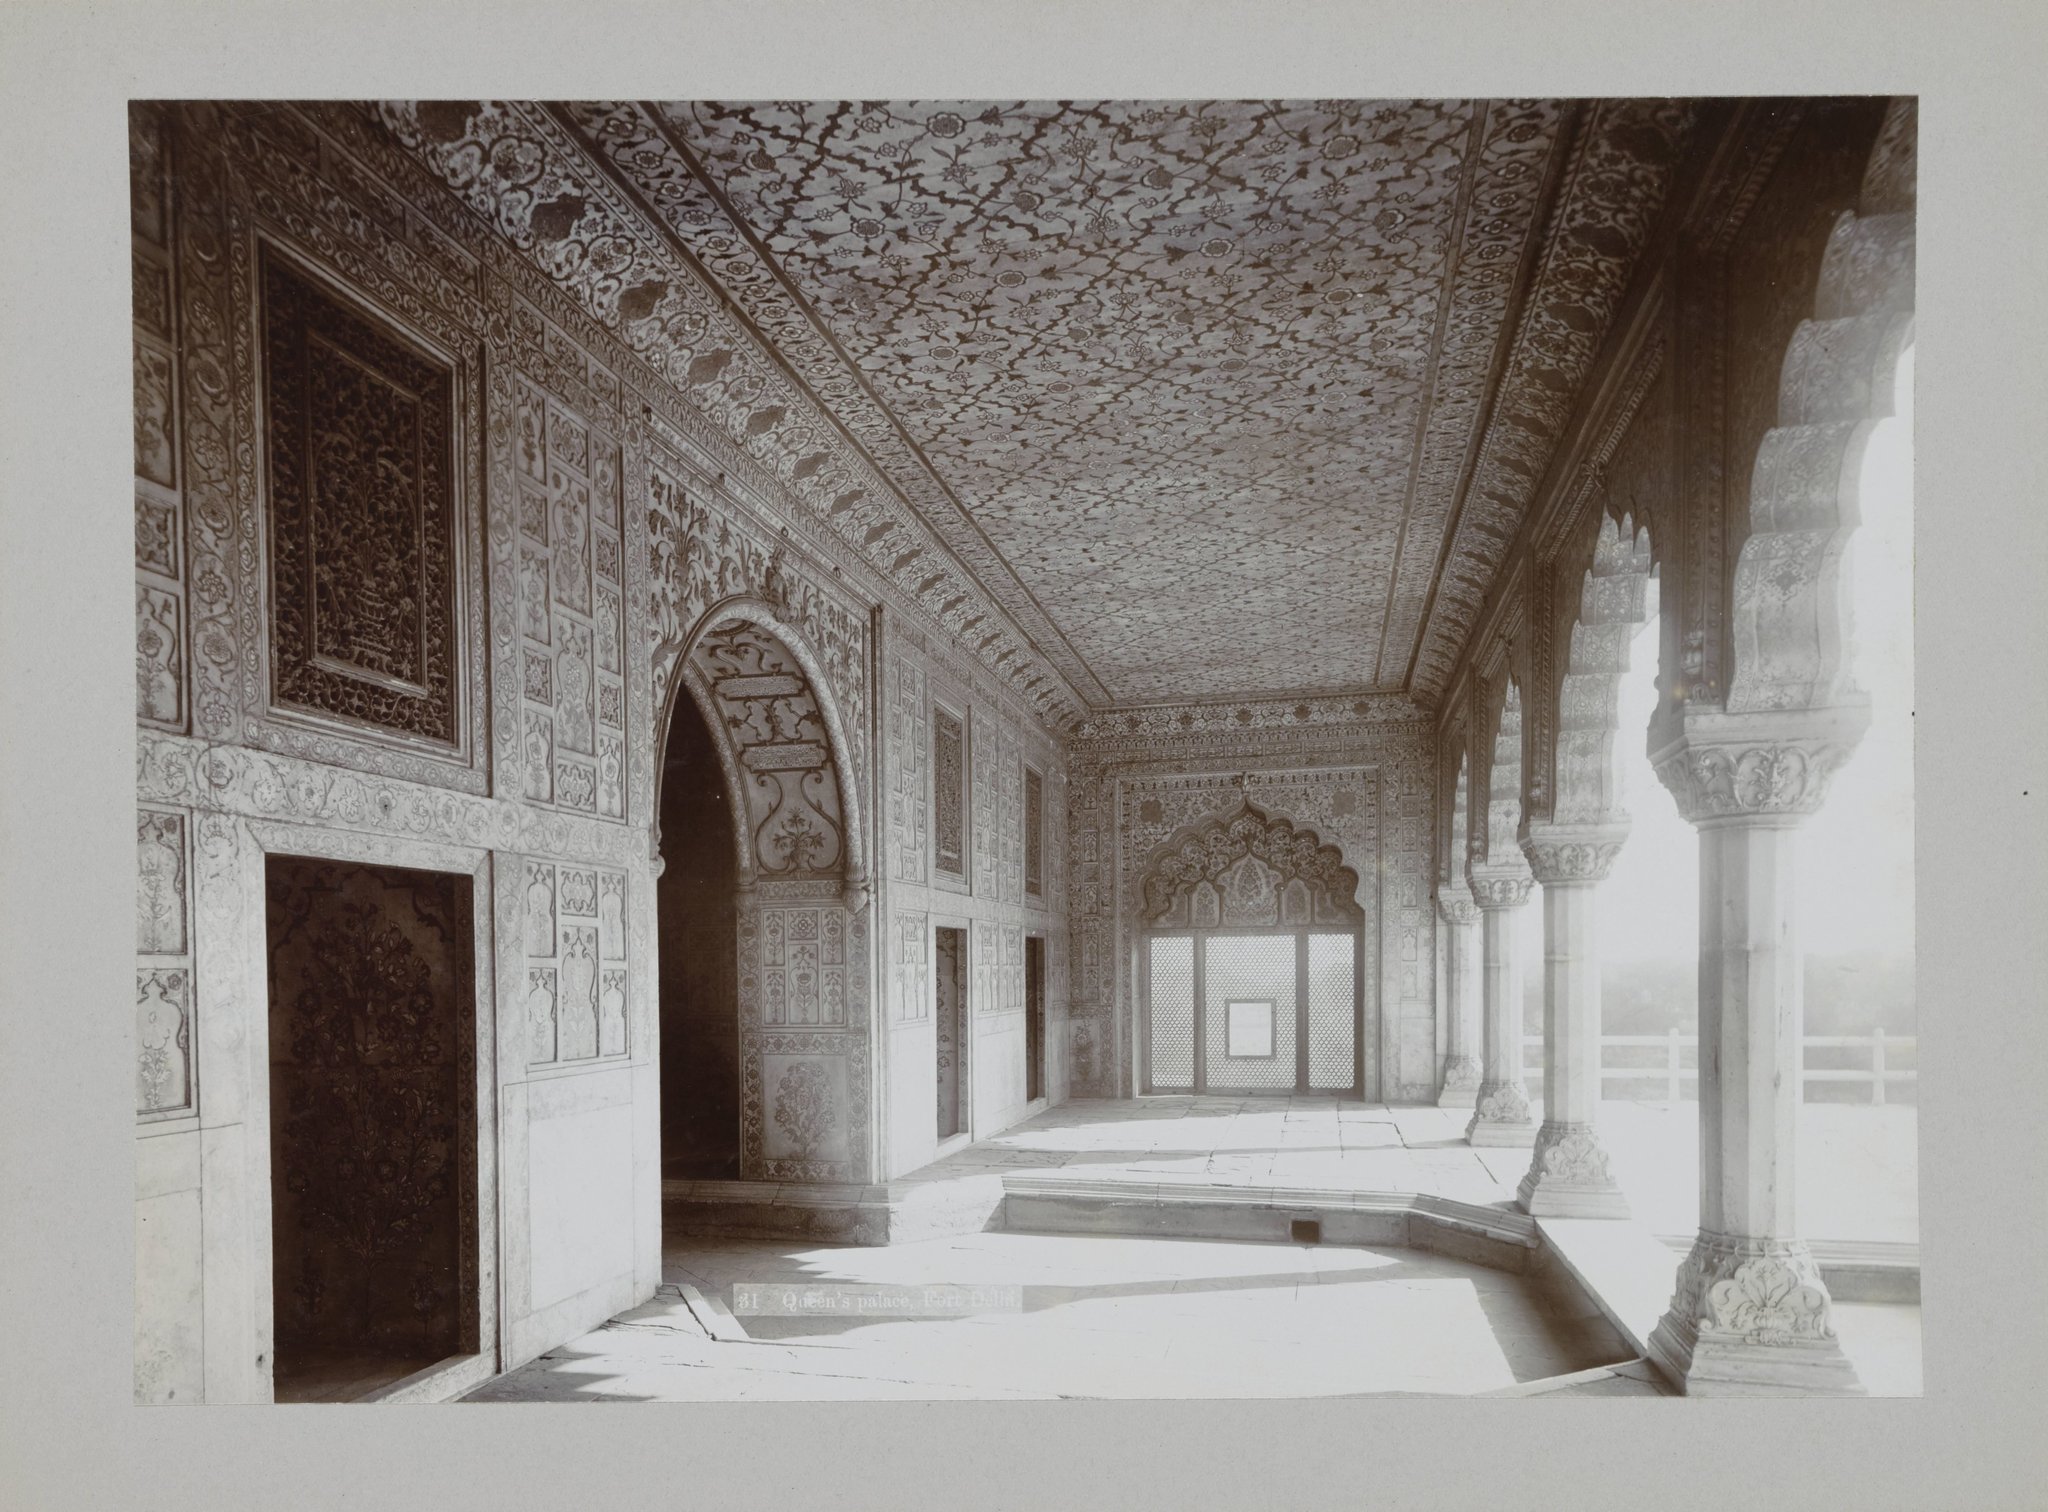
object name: photograph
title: Queen's Palace within the Red Fort at Delhi, India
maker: Anonymous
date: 1895-1915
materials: cardboard, paper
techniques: gelatin silver print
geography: delhi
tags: delhi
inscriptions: number: ‘30.’, inscription: ‘31 Queen's palace, Fort Delhi’